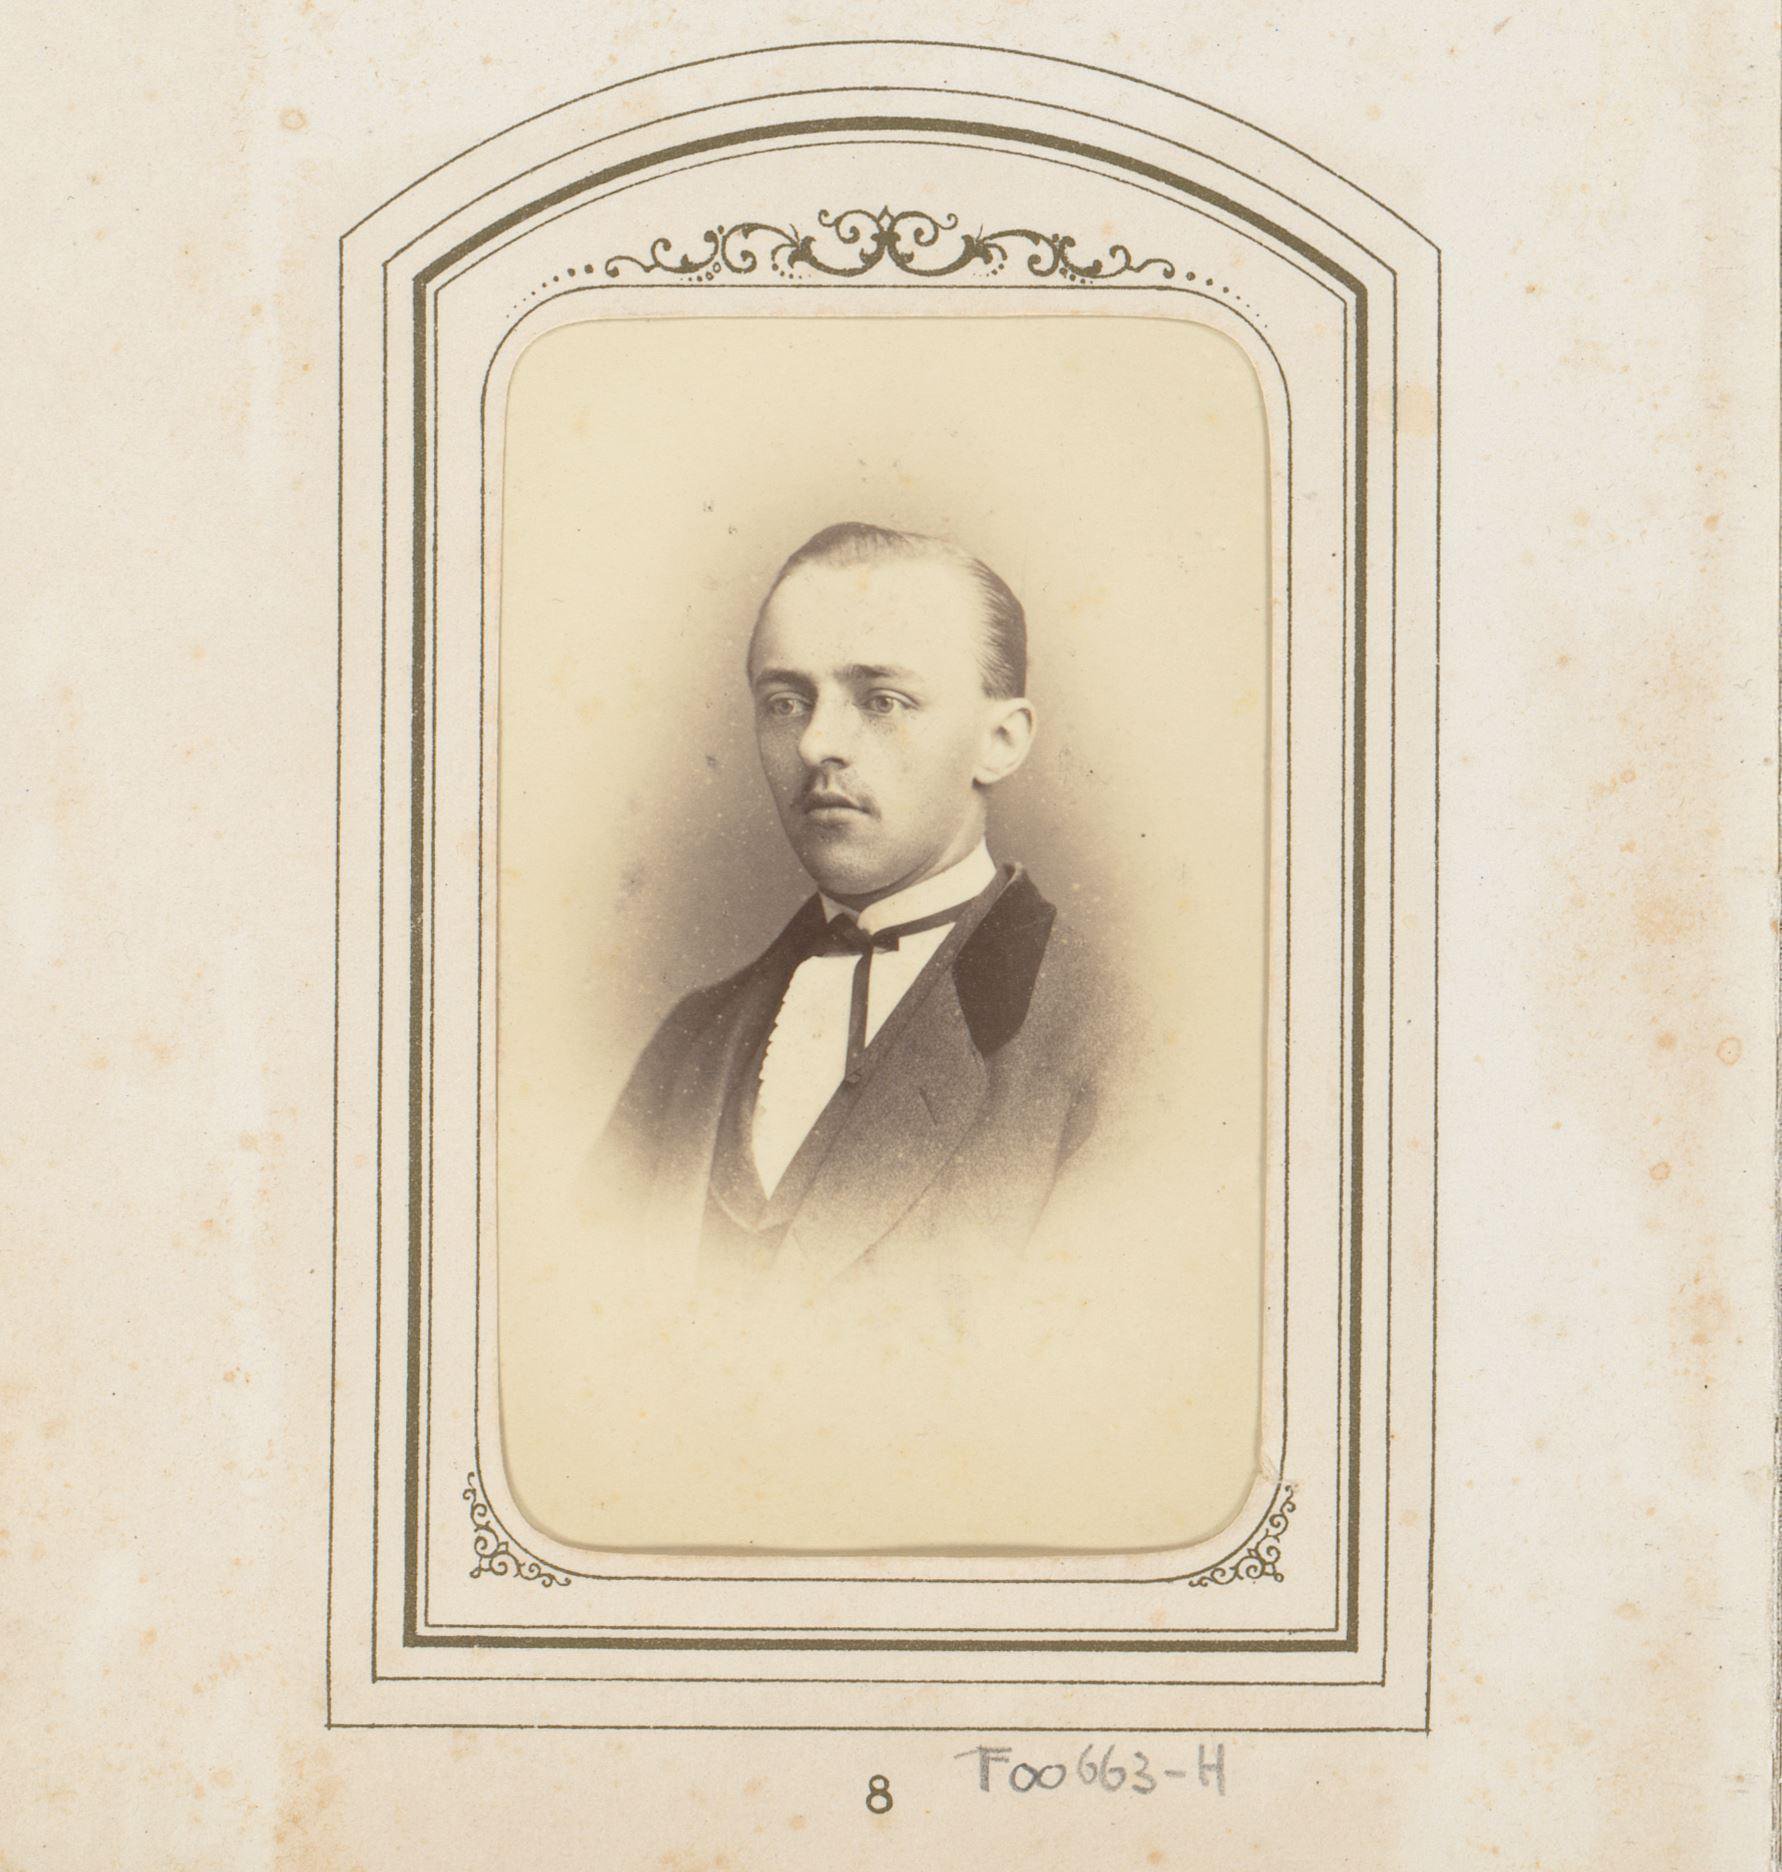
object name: photograph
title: Portret van een man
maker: f. springmeier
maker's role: fotograaf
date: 1860-1880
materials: cardboard, photographic support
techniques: albumen print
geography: amsterdam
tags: historical persons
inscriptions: inscription: ‘F. Springmeier/ Photograph/ Elberfeld/ Herzogstrasse, No.4.’, number: ‘8’